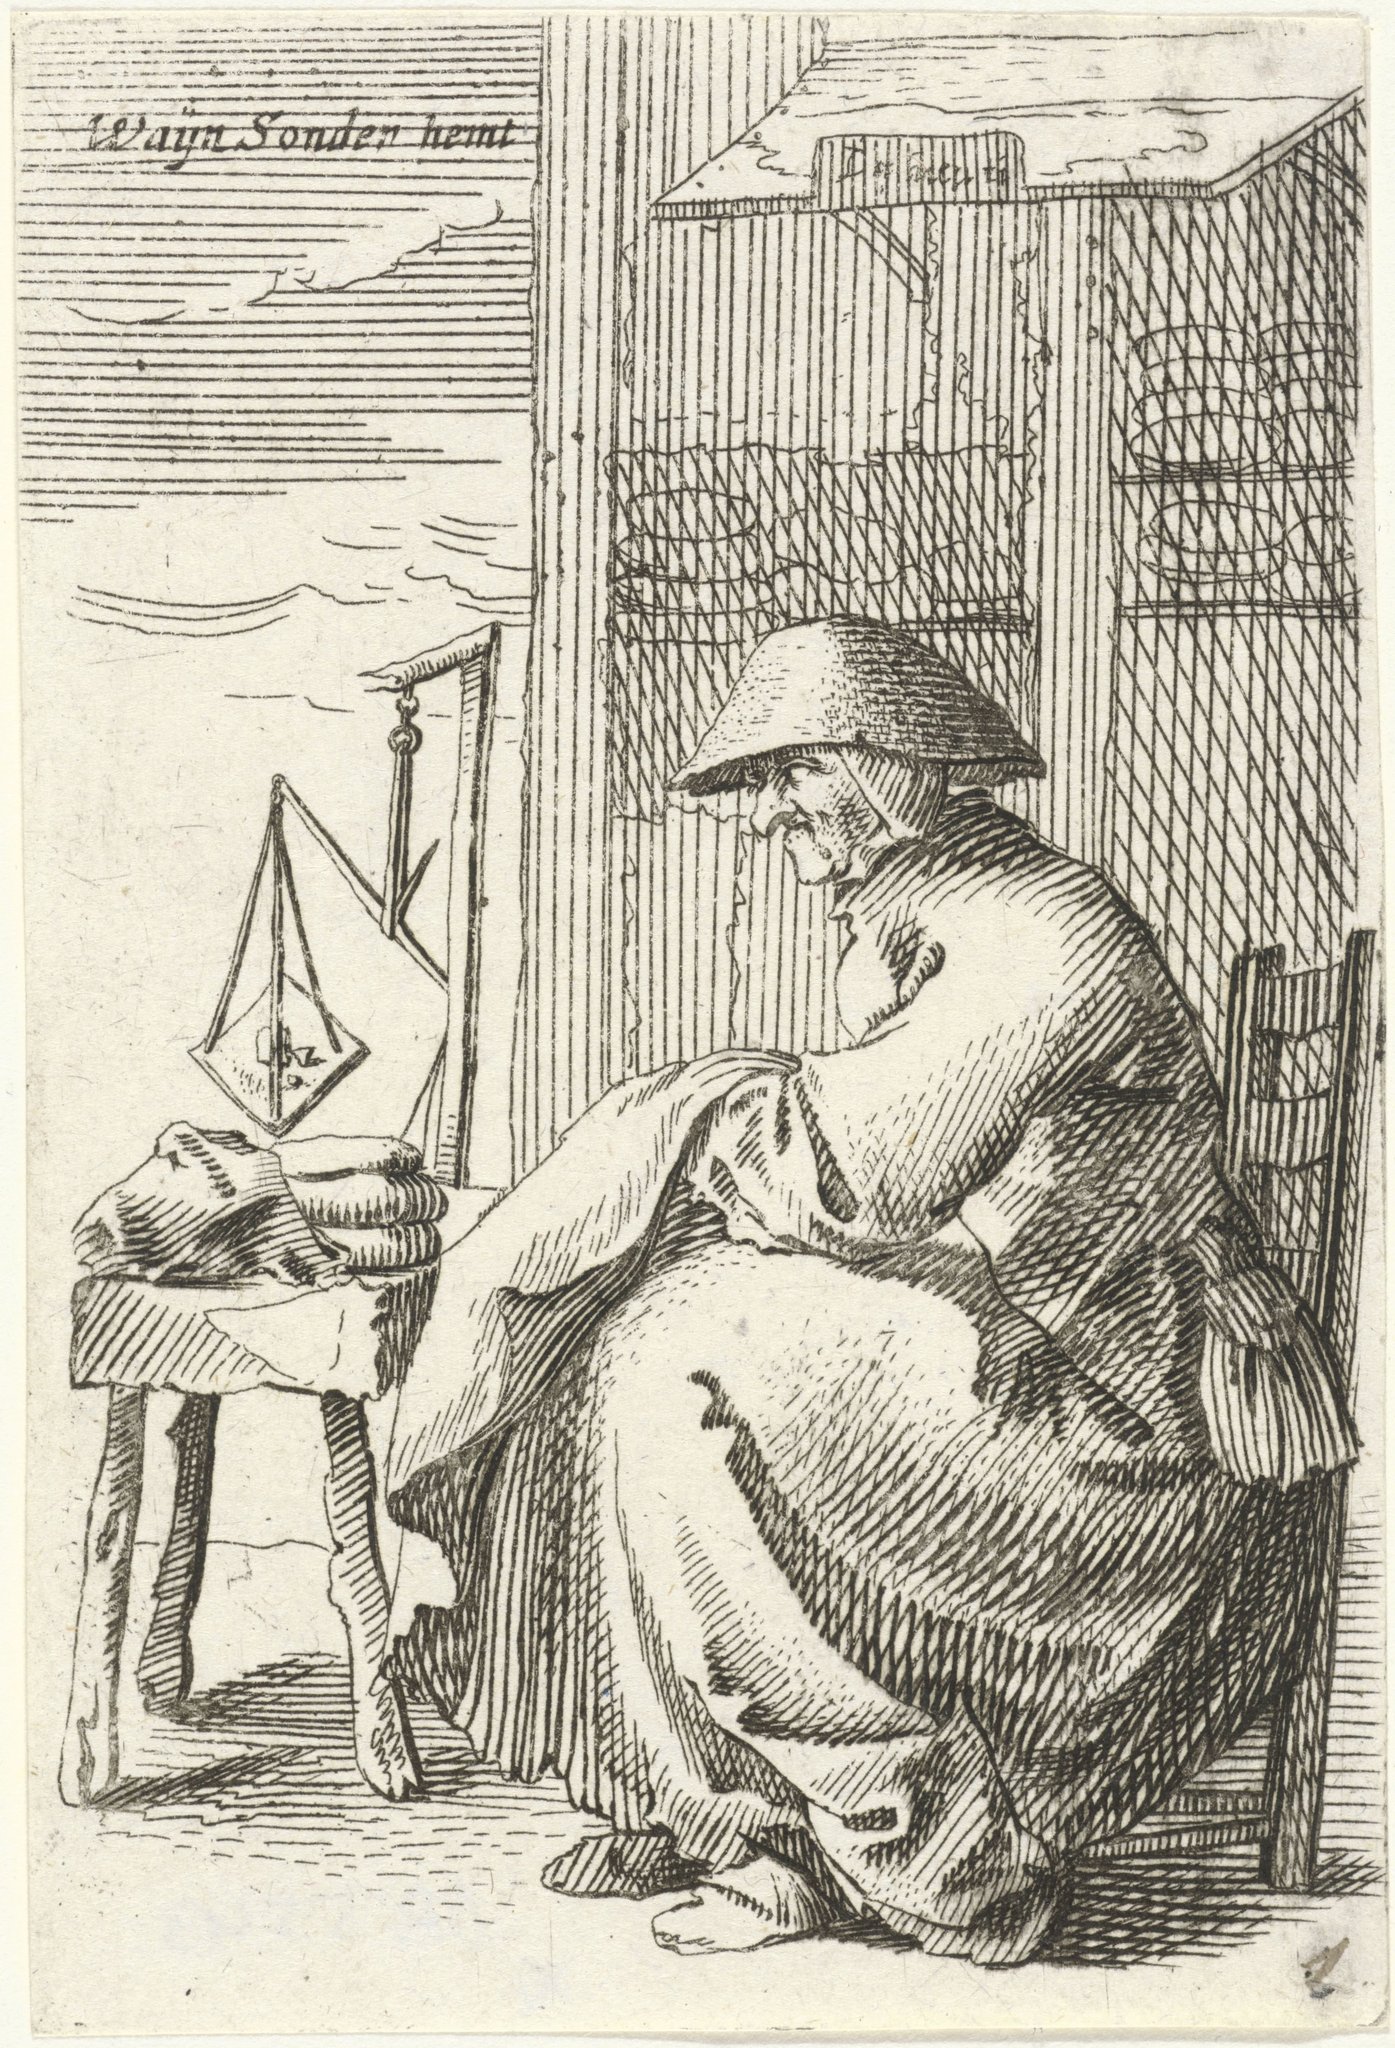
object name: print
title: Wayn Sonder hemt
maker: Anonymous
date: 1630-1665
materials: paper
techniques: engraving, etching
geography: amsterdam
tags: farmers, weighing-instruments, textile fabric, cloth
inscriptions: number: ‘4’, collector's mark: Lugt 2228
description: Spiegelbeeldige kopie naar prent uit de twaalfdelige serie "T'Leven Der Boeren" van Salomon Savery naar Pieter Jansz. Quast. De gehele serie is door deze anonieme prentmaker gekopieerd.